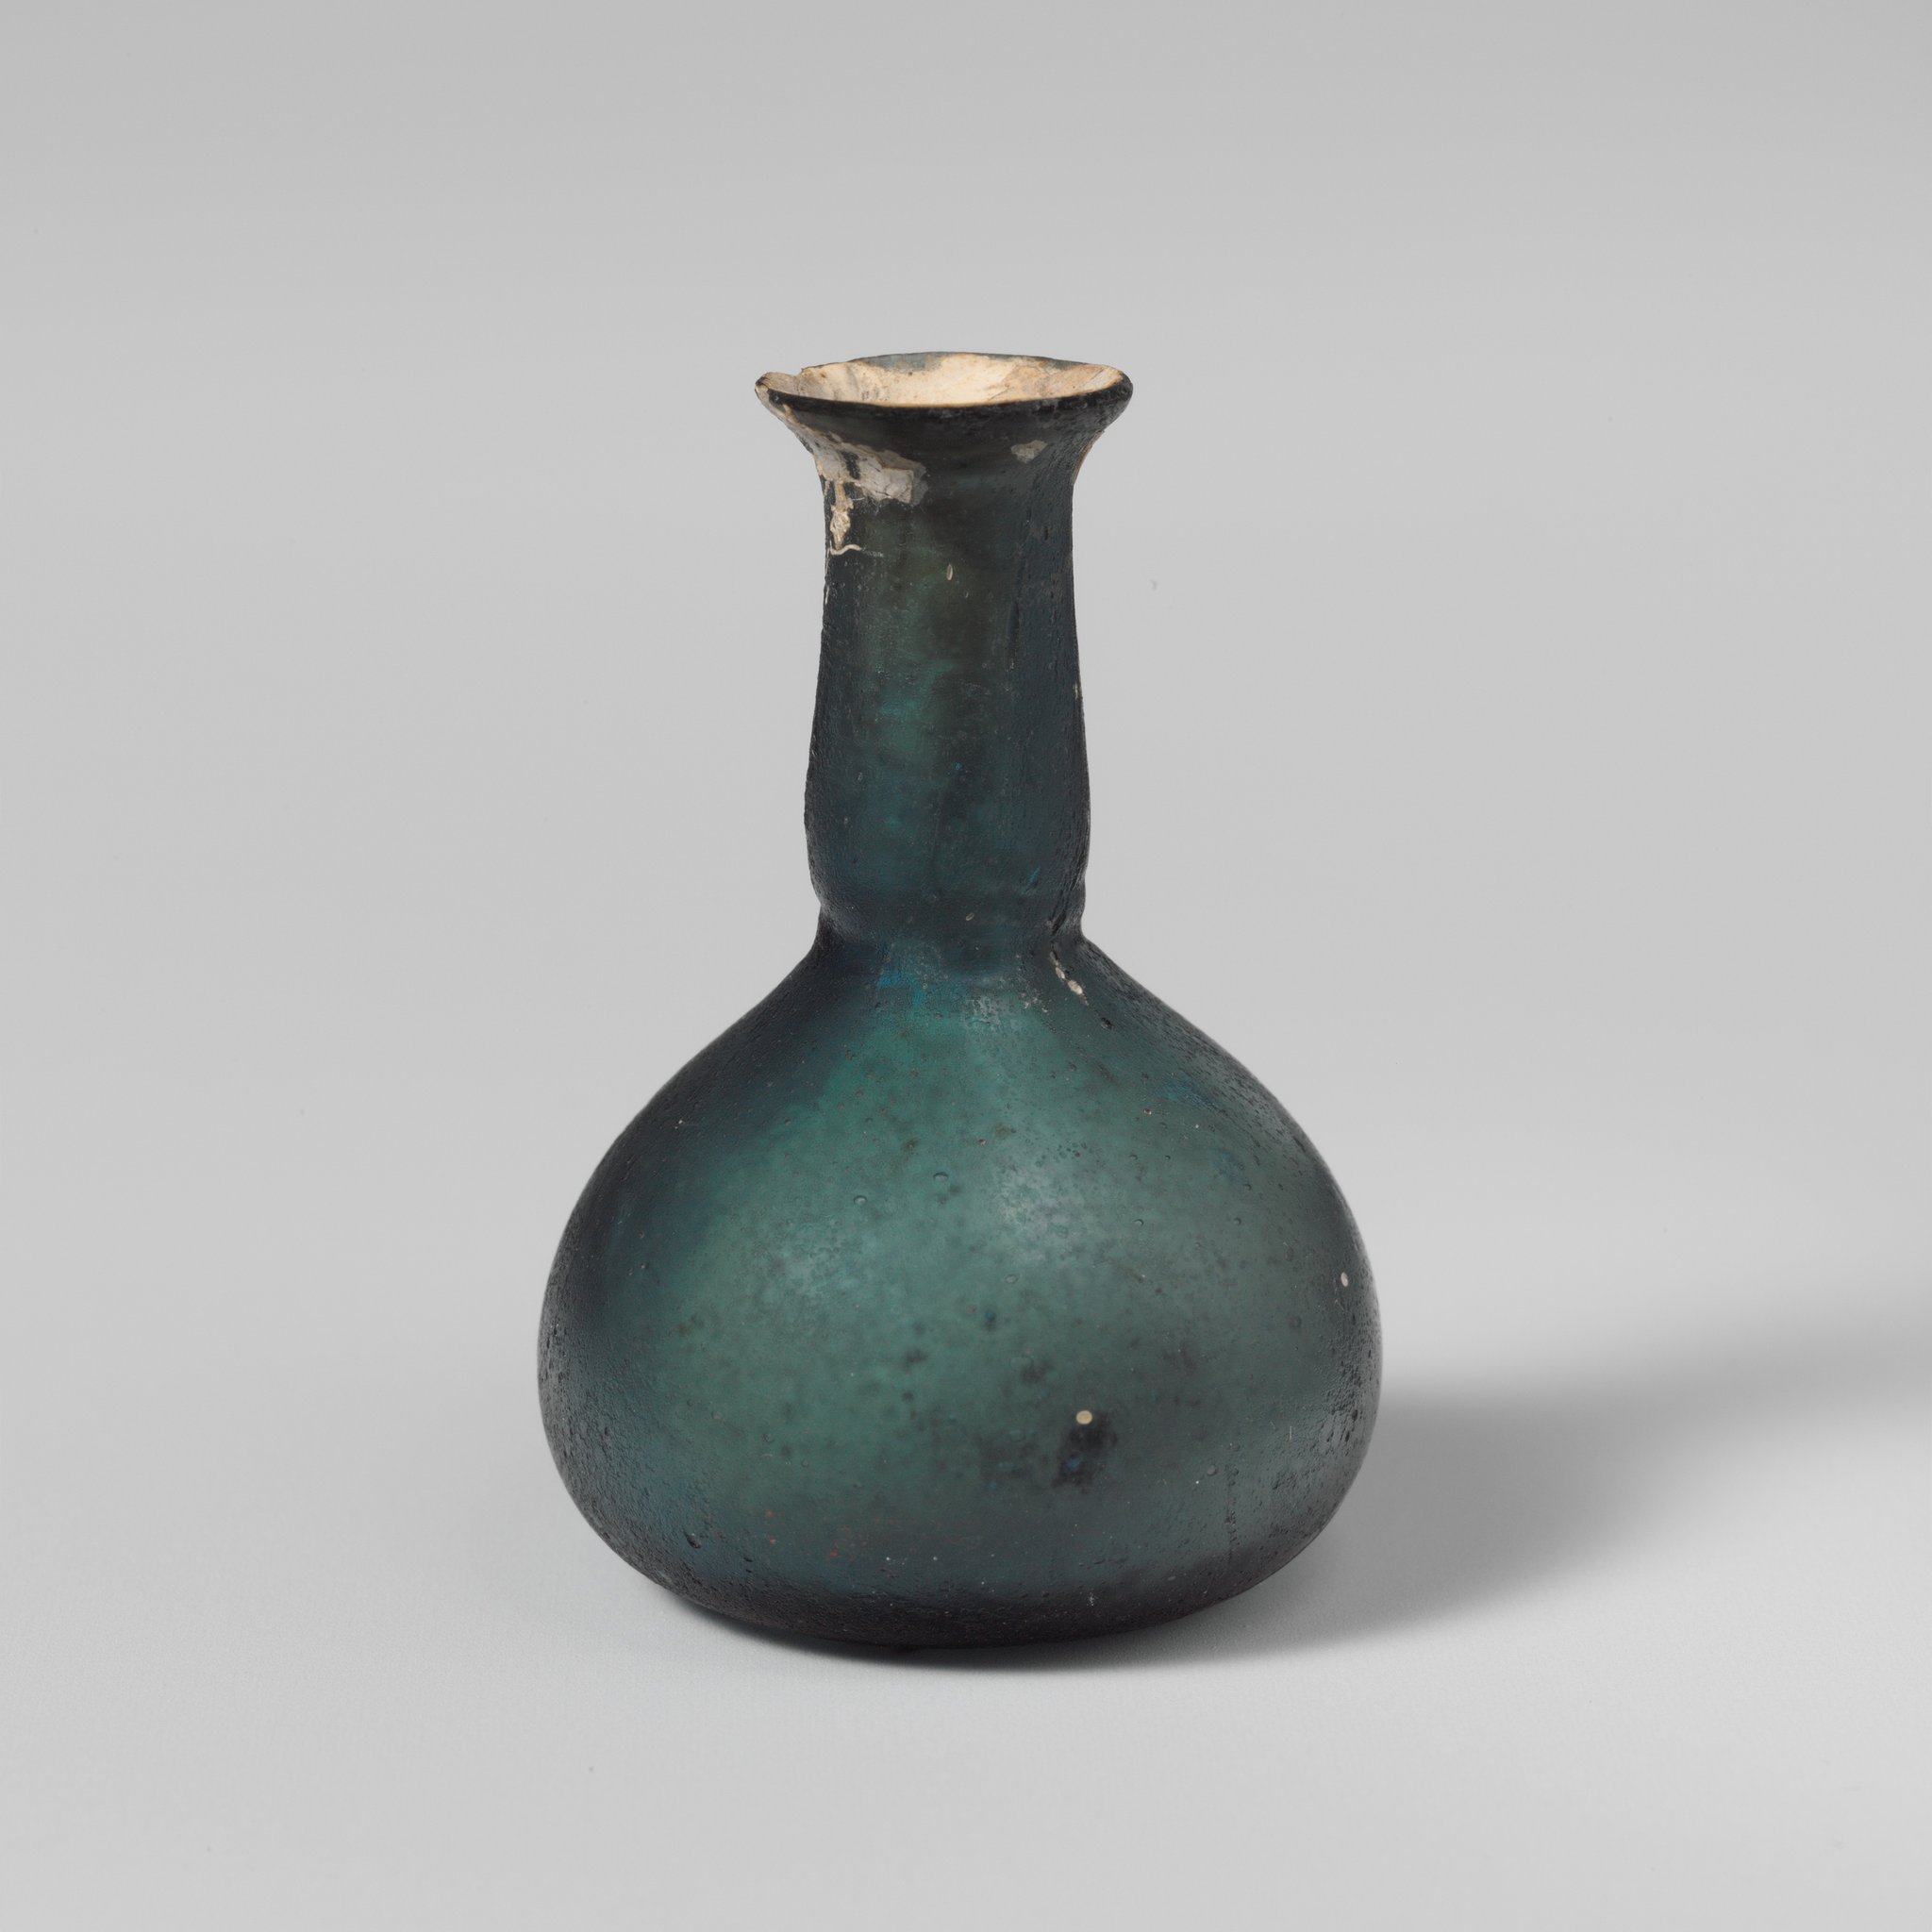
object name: perfume bottle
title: Glass perfume bottle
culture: roman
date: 1-100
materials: glass